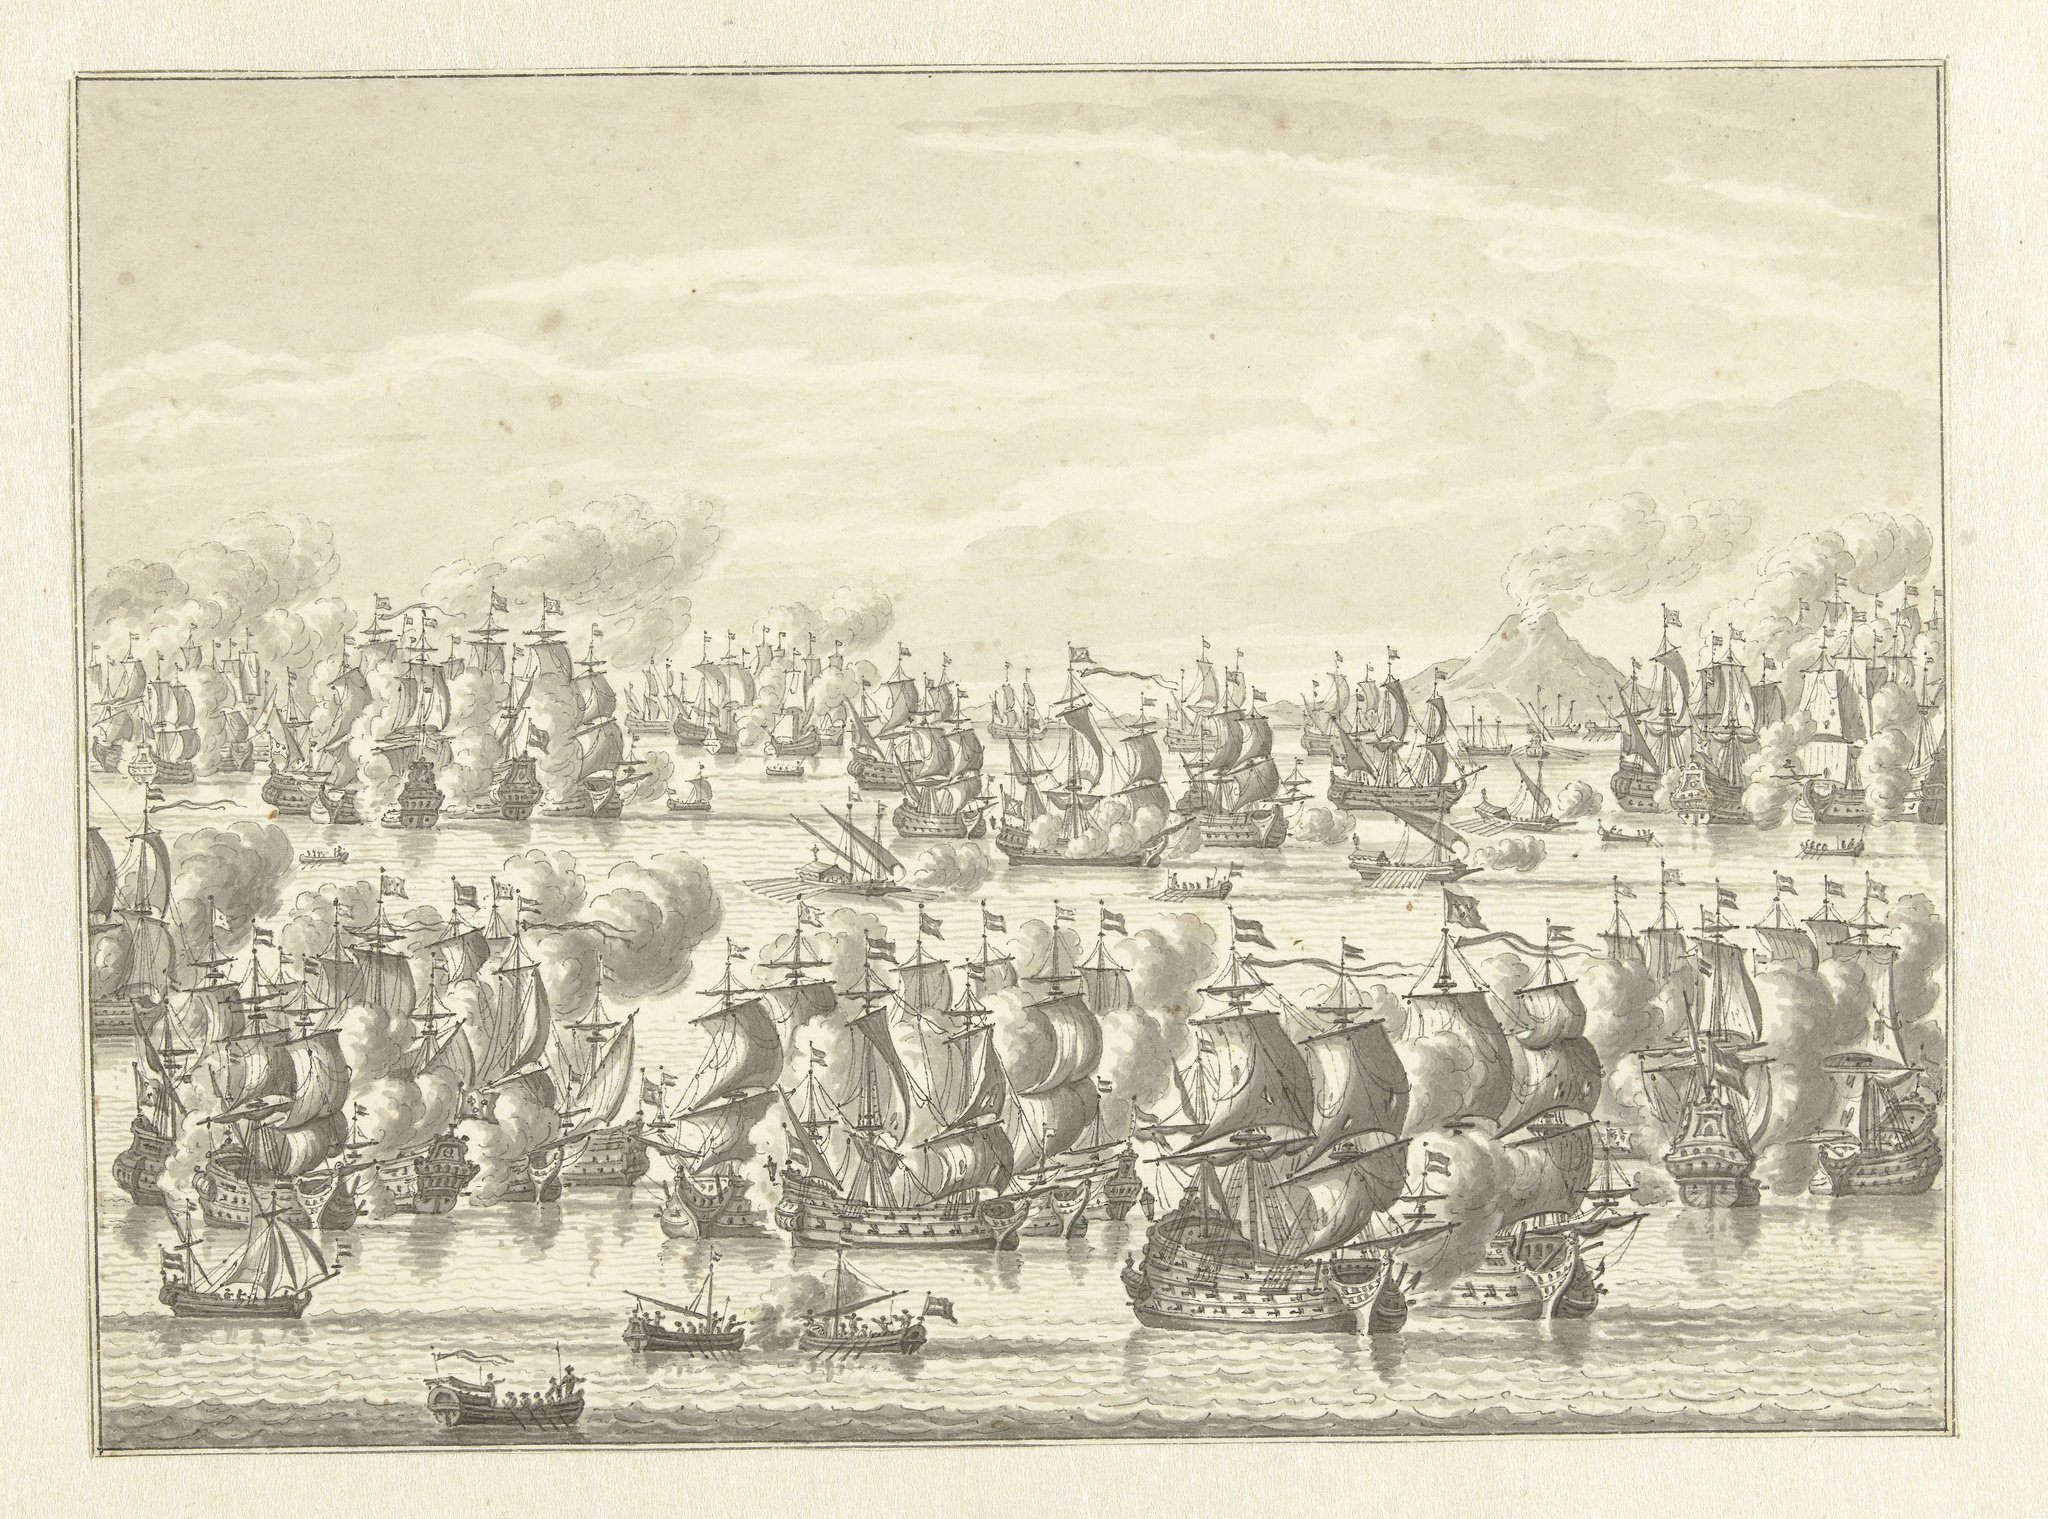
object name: drawing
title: Zeeslag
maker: jan bulthuis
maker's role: draughtsman, print maker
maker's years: 1750-1801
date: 1760-1801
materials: ink, paper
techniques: brush, pen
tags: battle (+ naval force)